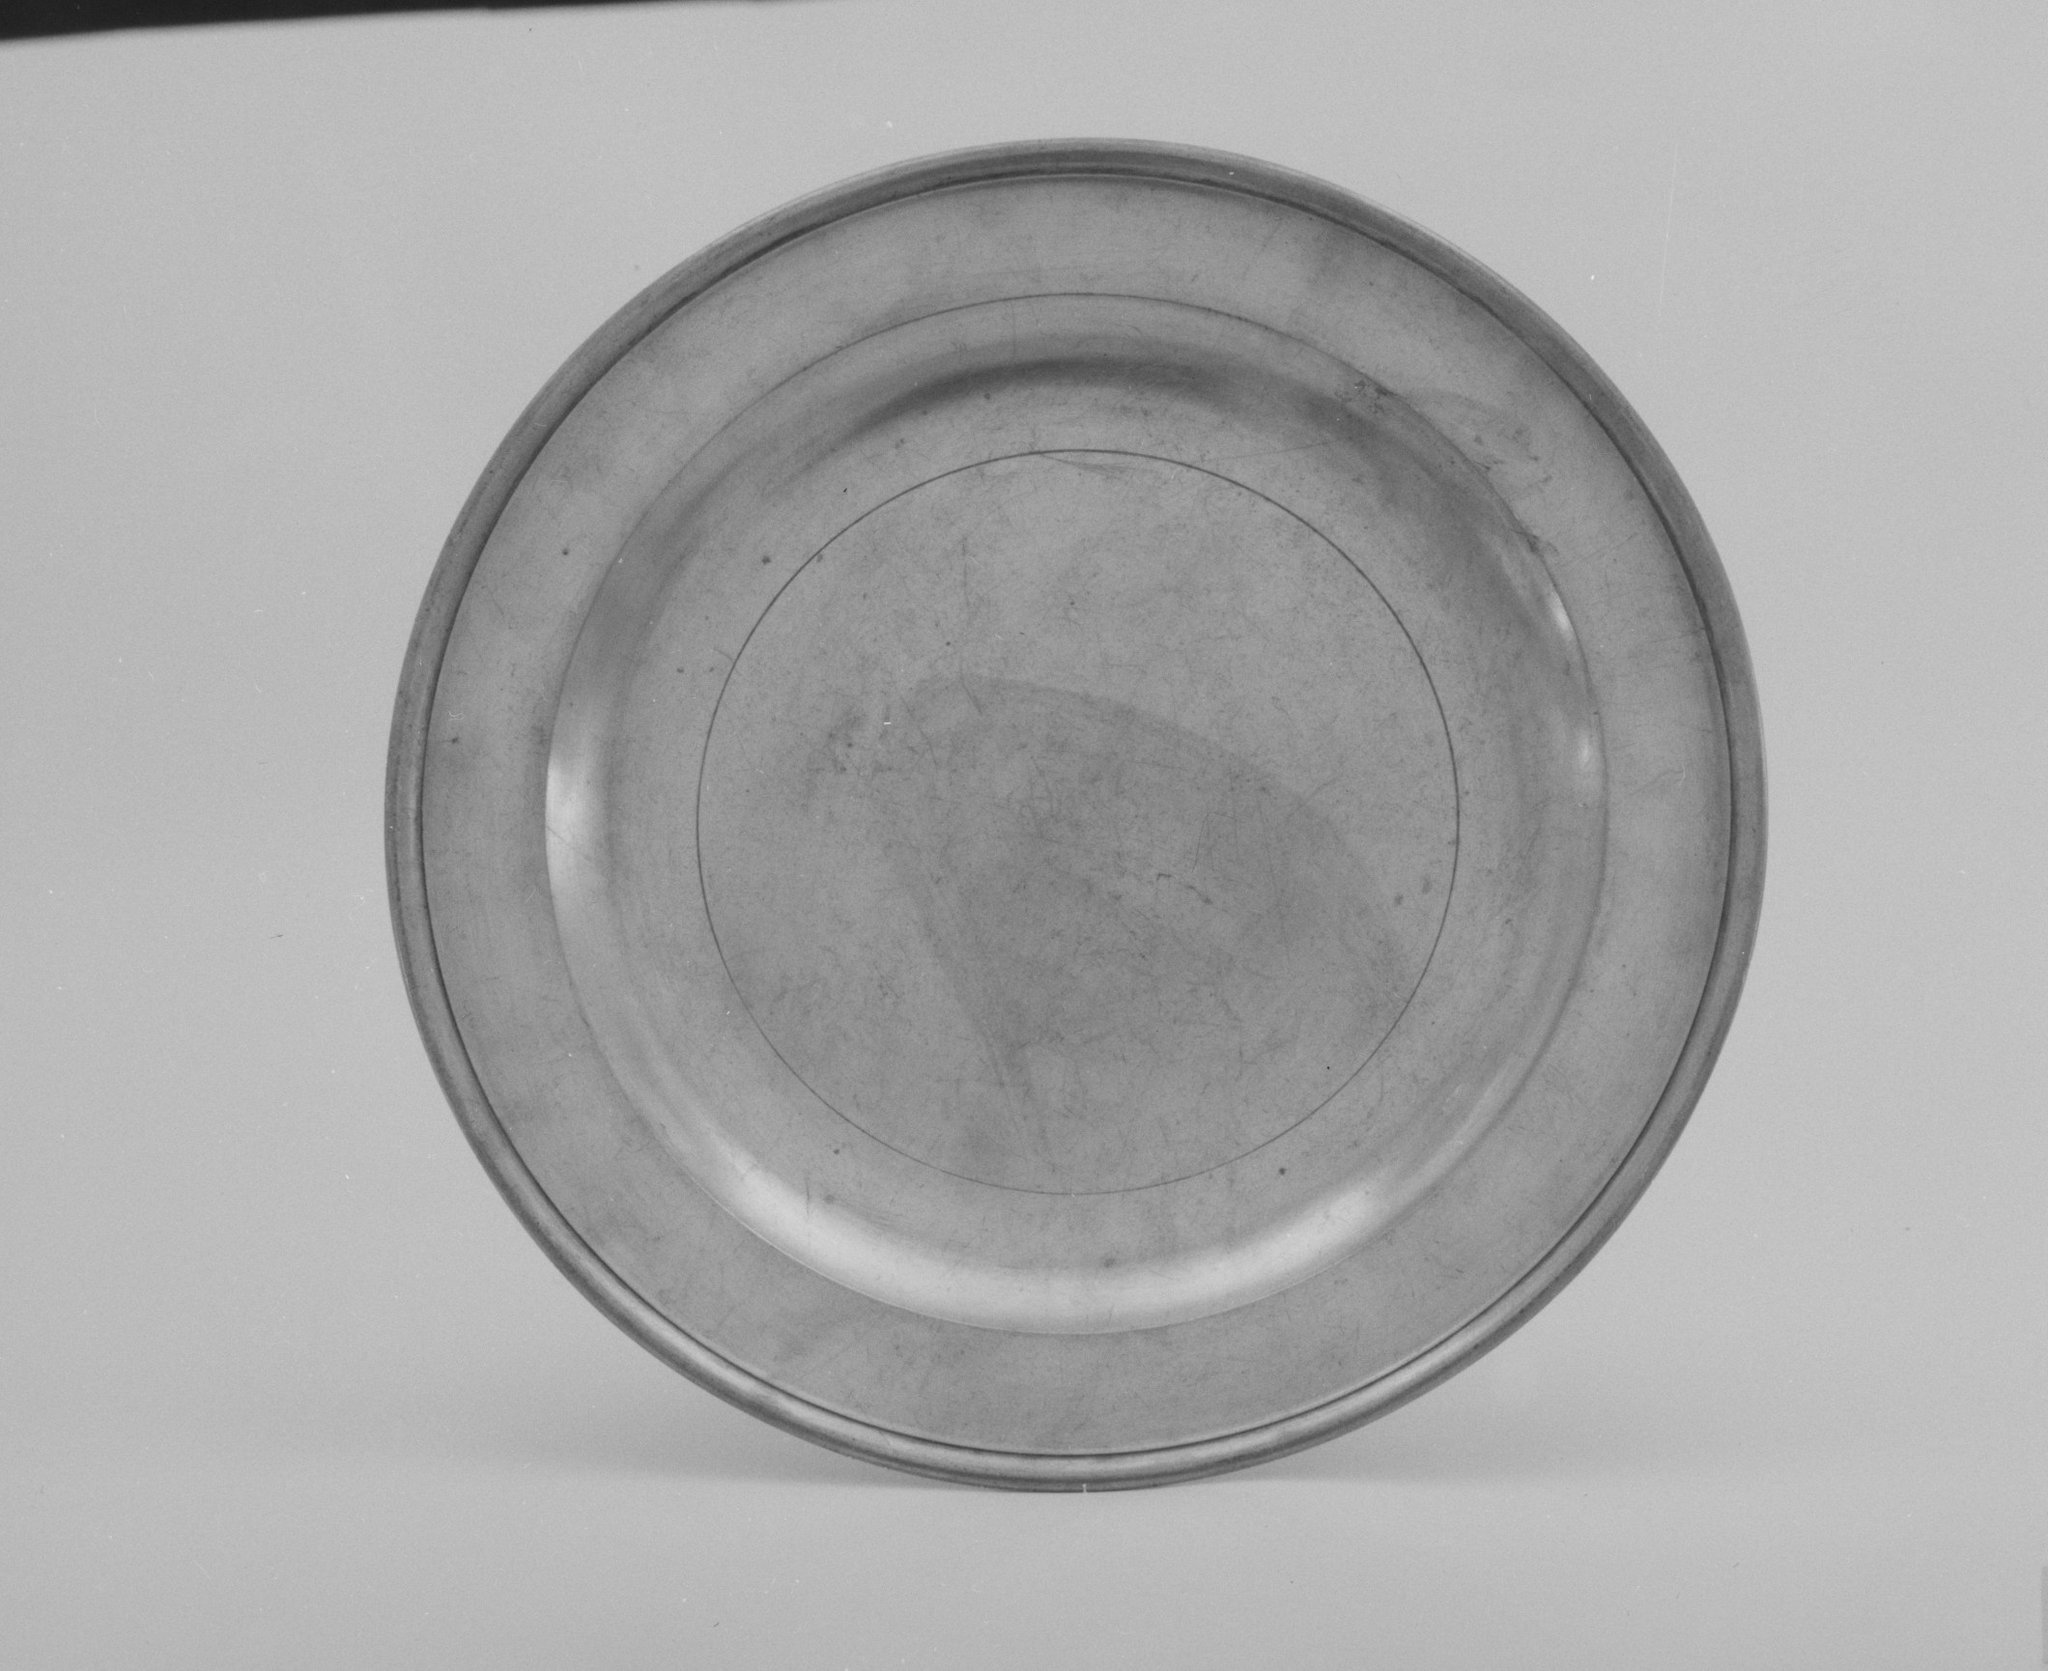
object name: dish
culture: american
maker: richard austin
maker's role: maker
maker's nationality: american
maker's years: 1767-1817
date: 1793-1807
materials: pewter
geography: united states